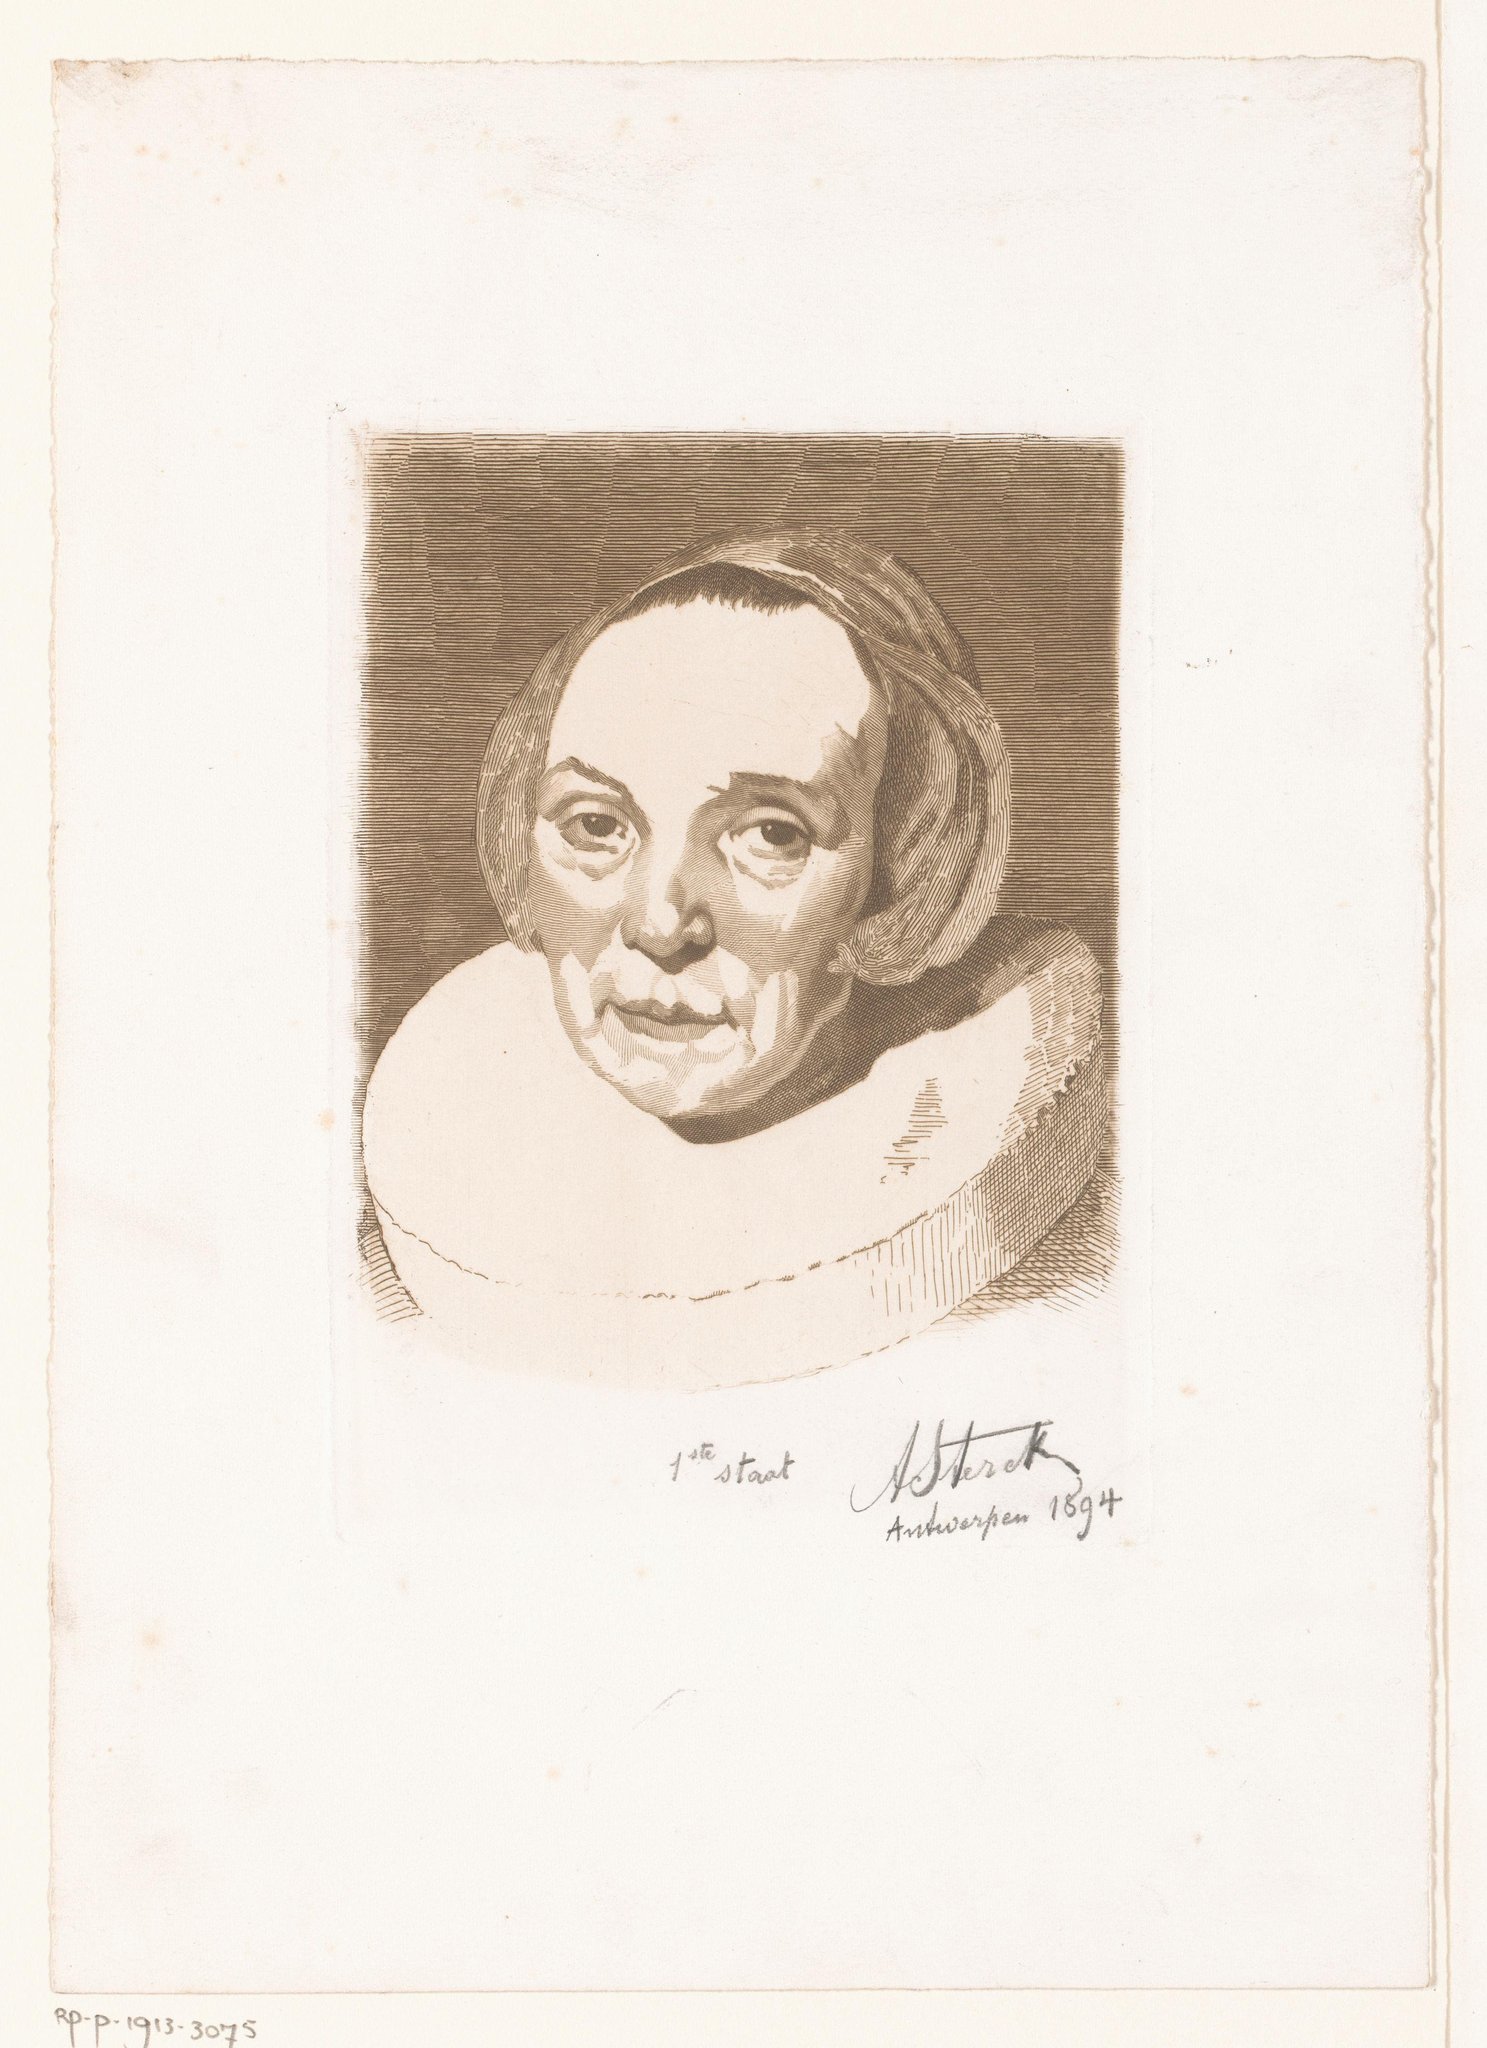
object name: print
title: Buste van een onbekende Nederlandse vrouw met plooikraag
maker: arthur sterck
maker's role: print maker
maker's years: 1868-1897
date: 1894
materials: paper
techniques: etching, intaglio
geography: antwerp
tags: adult woman, neck-gear ~ clothing (with name), neck-gear: collar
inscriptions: annotation: ‘1ste staat’, collector's mark: Lugt 2228